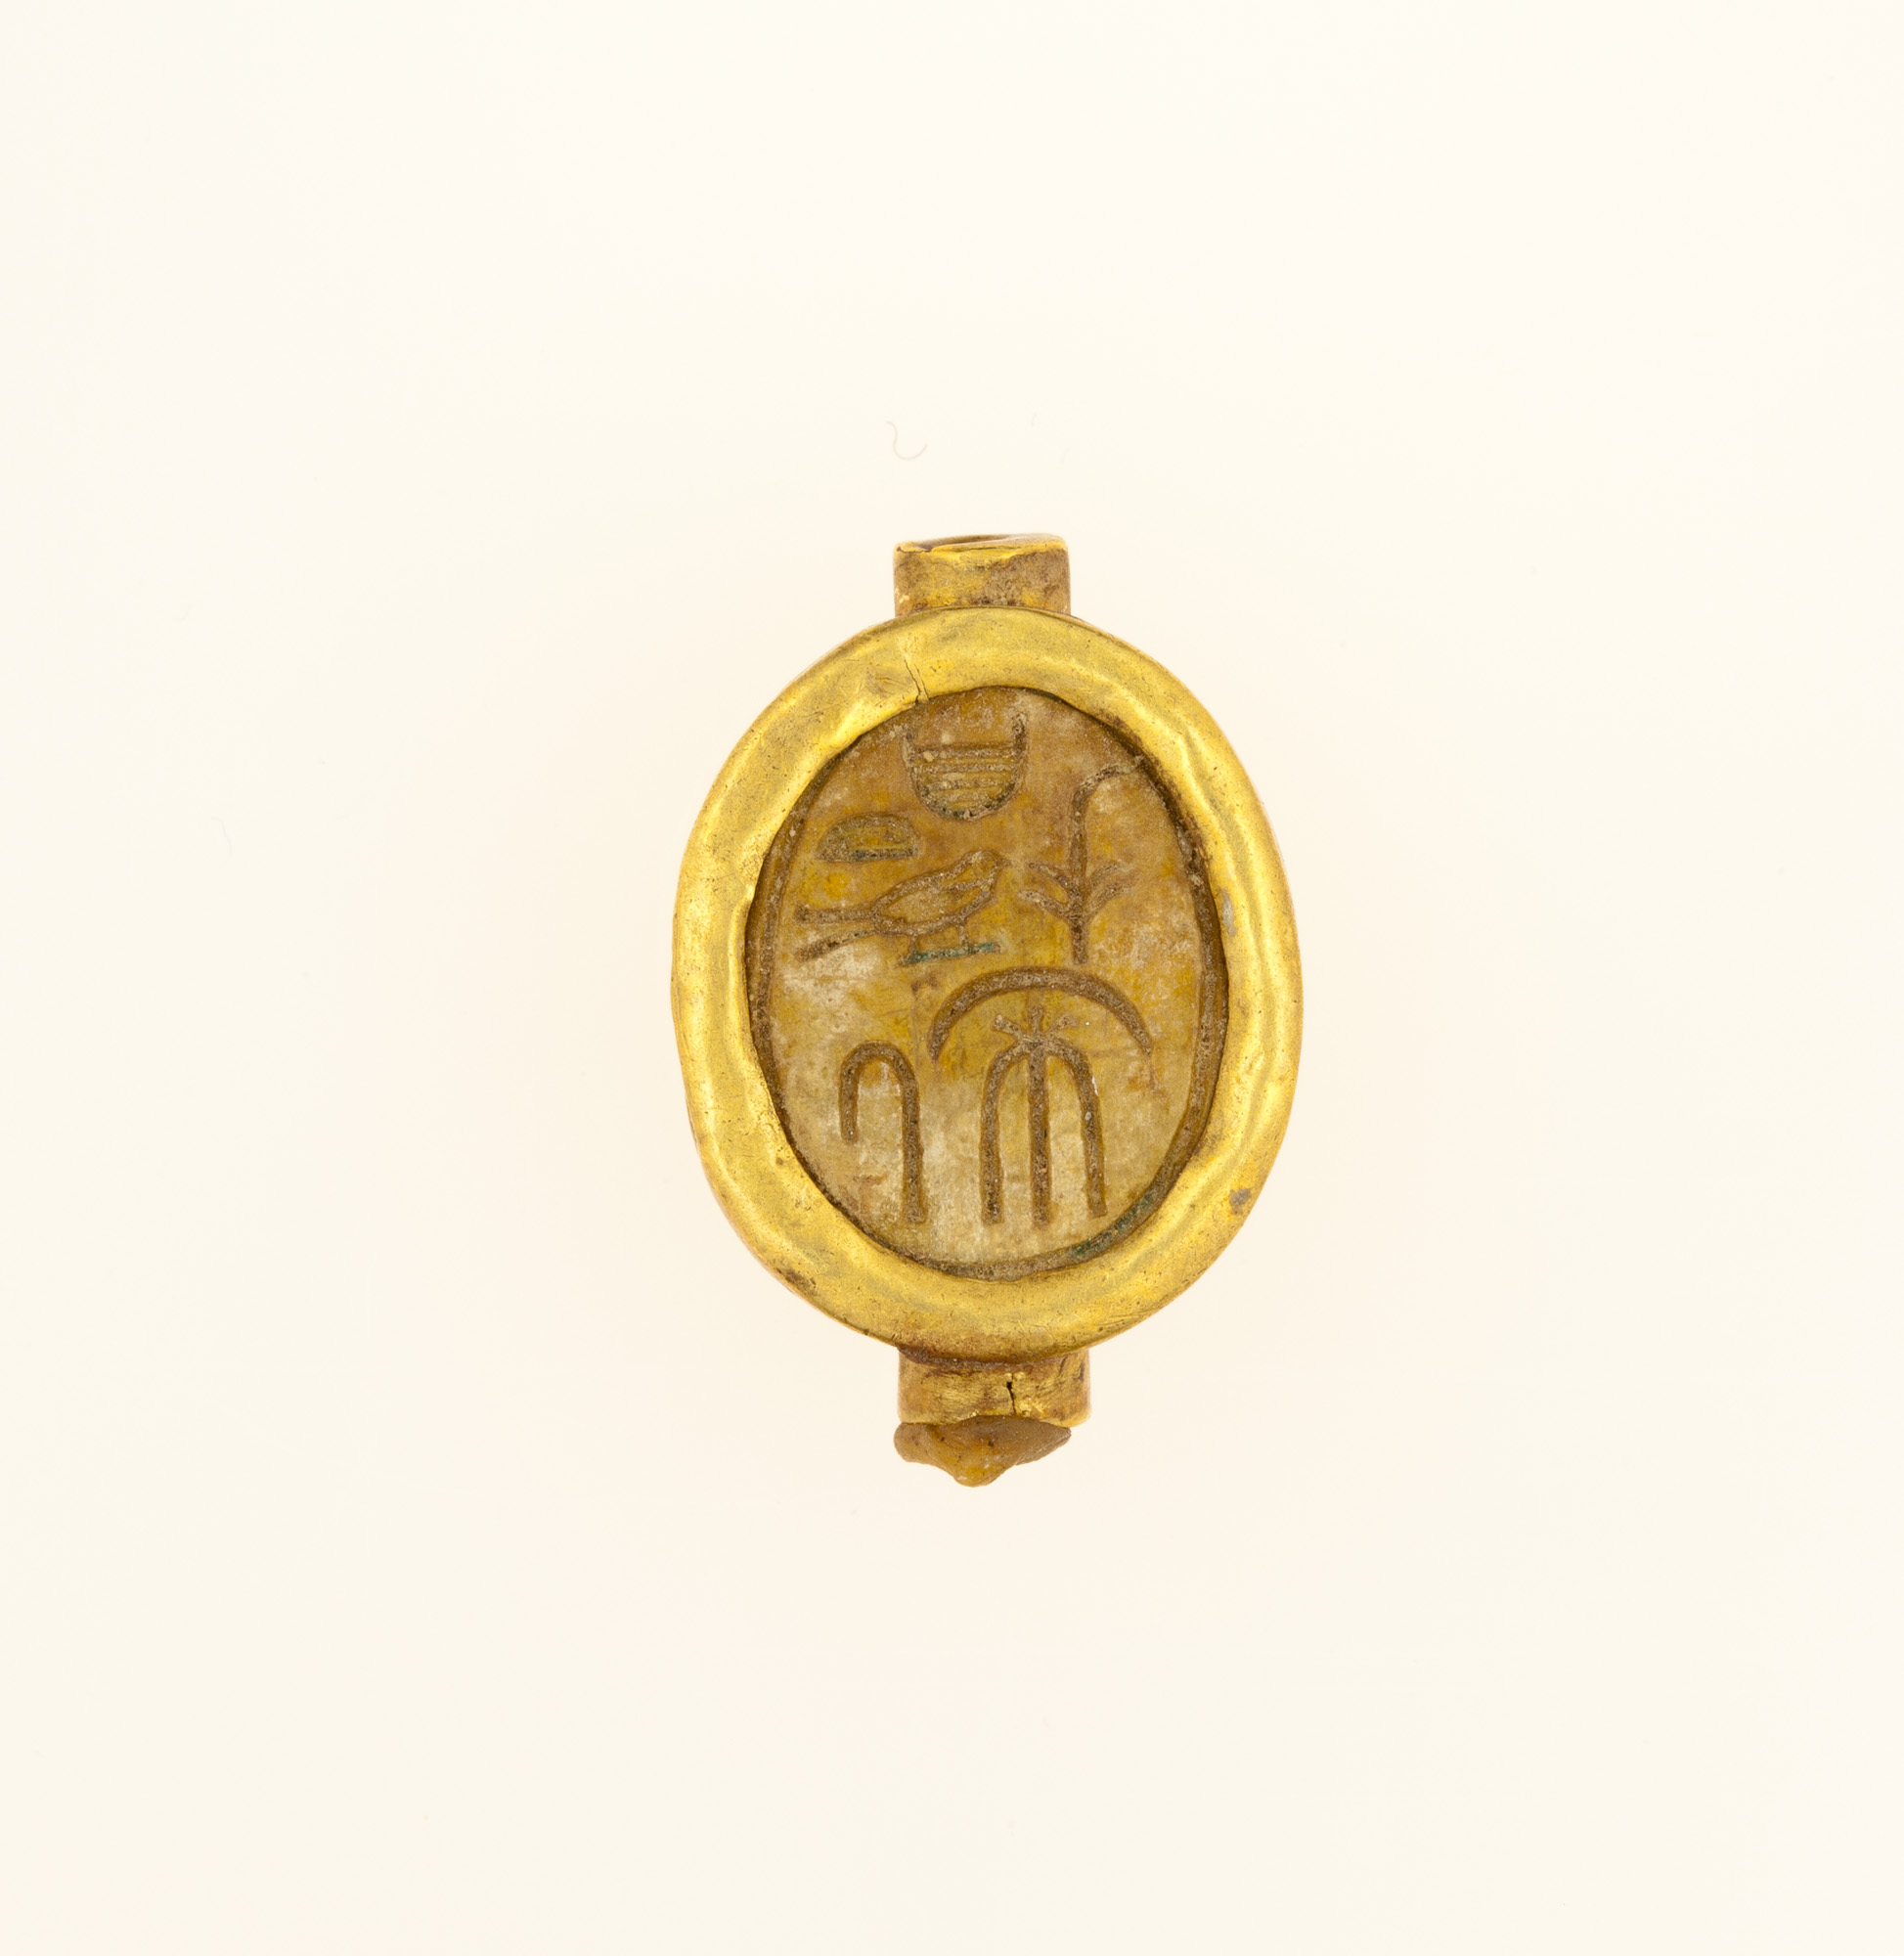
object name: scarab, ring bezel, queen of king ahmose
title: Scarab with Name of the Queen of King Ahmose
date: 1550-1525 BCE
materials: gold, stone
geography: egypt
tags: hieroglyphs